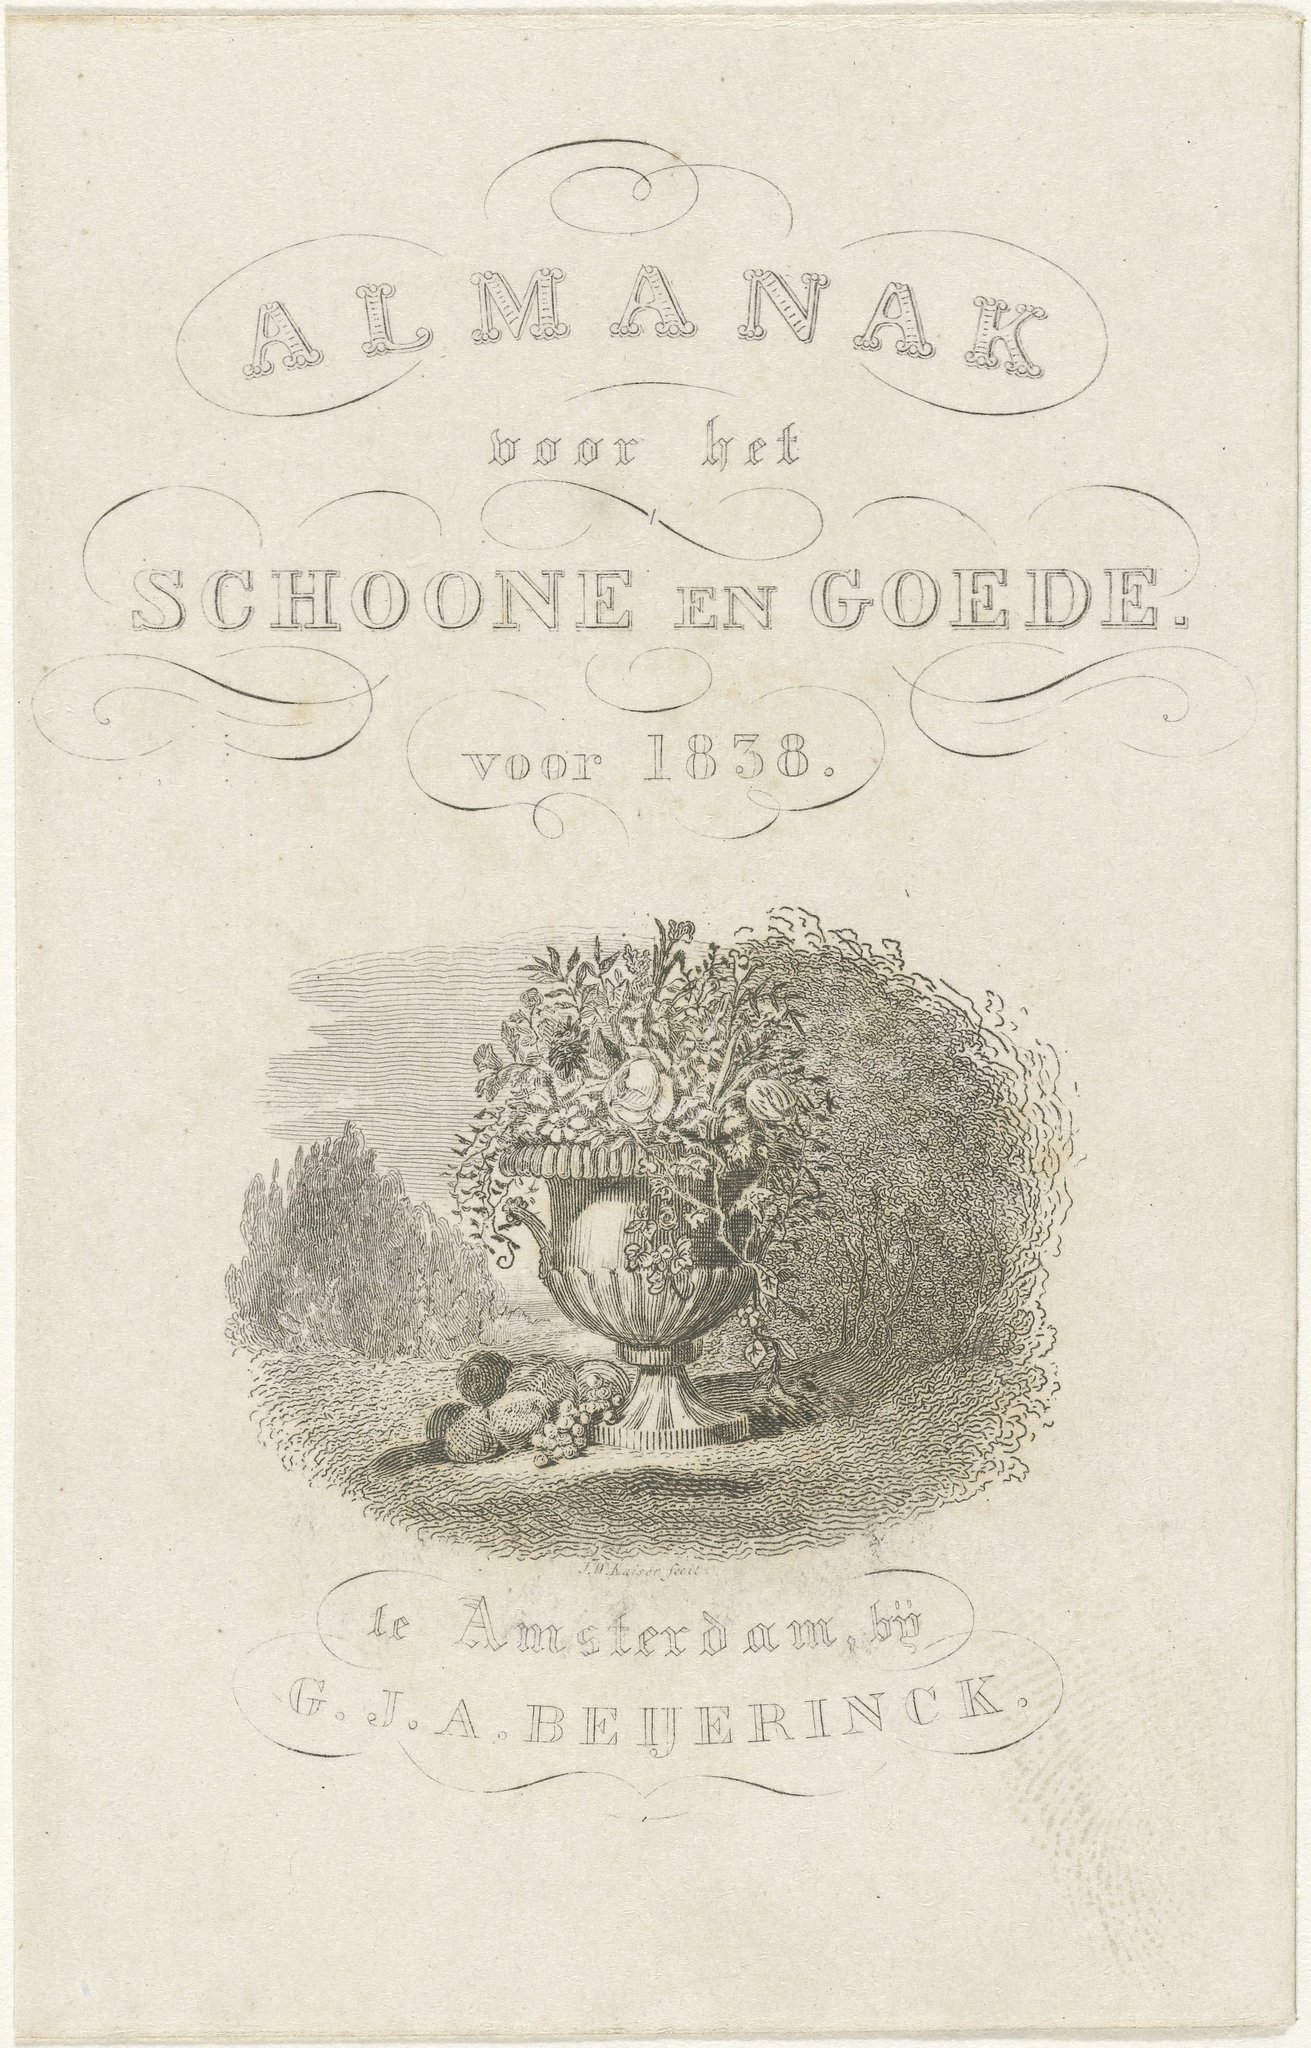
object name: titelblad, titelpagina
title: Titelpagina voor de Almanak voor het Schoone en Goede, 1838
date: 1838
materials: paper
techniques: etching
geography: netherlands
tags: cut flowers; nosegay, bunch of flowers, landscapes, fruits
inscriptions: collector's mark: Lugt 2228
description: Titelpagina voor de Almanak voor het Schoone en Goede, met een landschap met daarin een bokaal die gevuld is met bloemen en fruit.